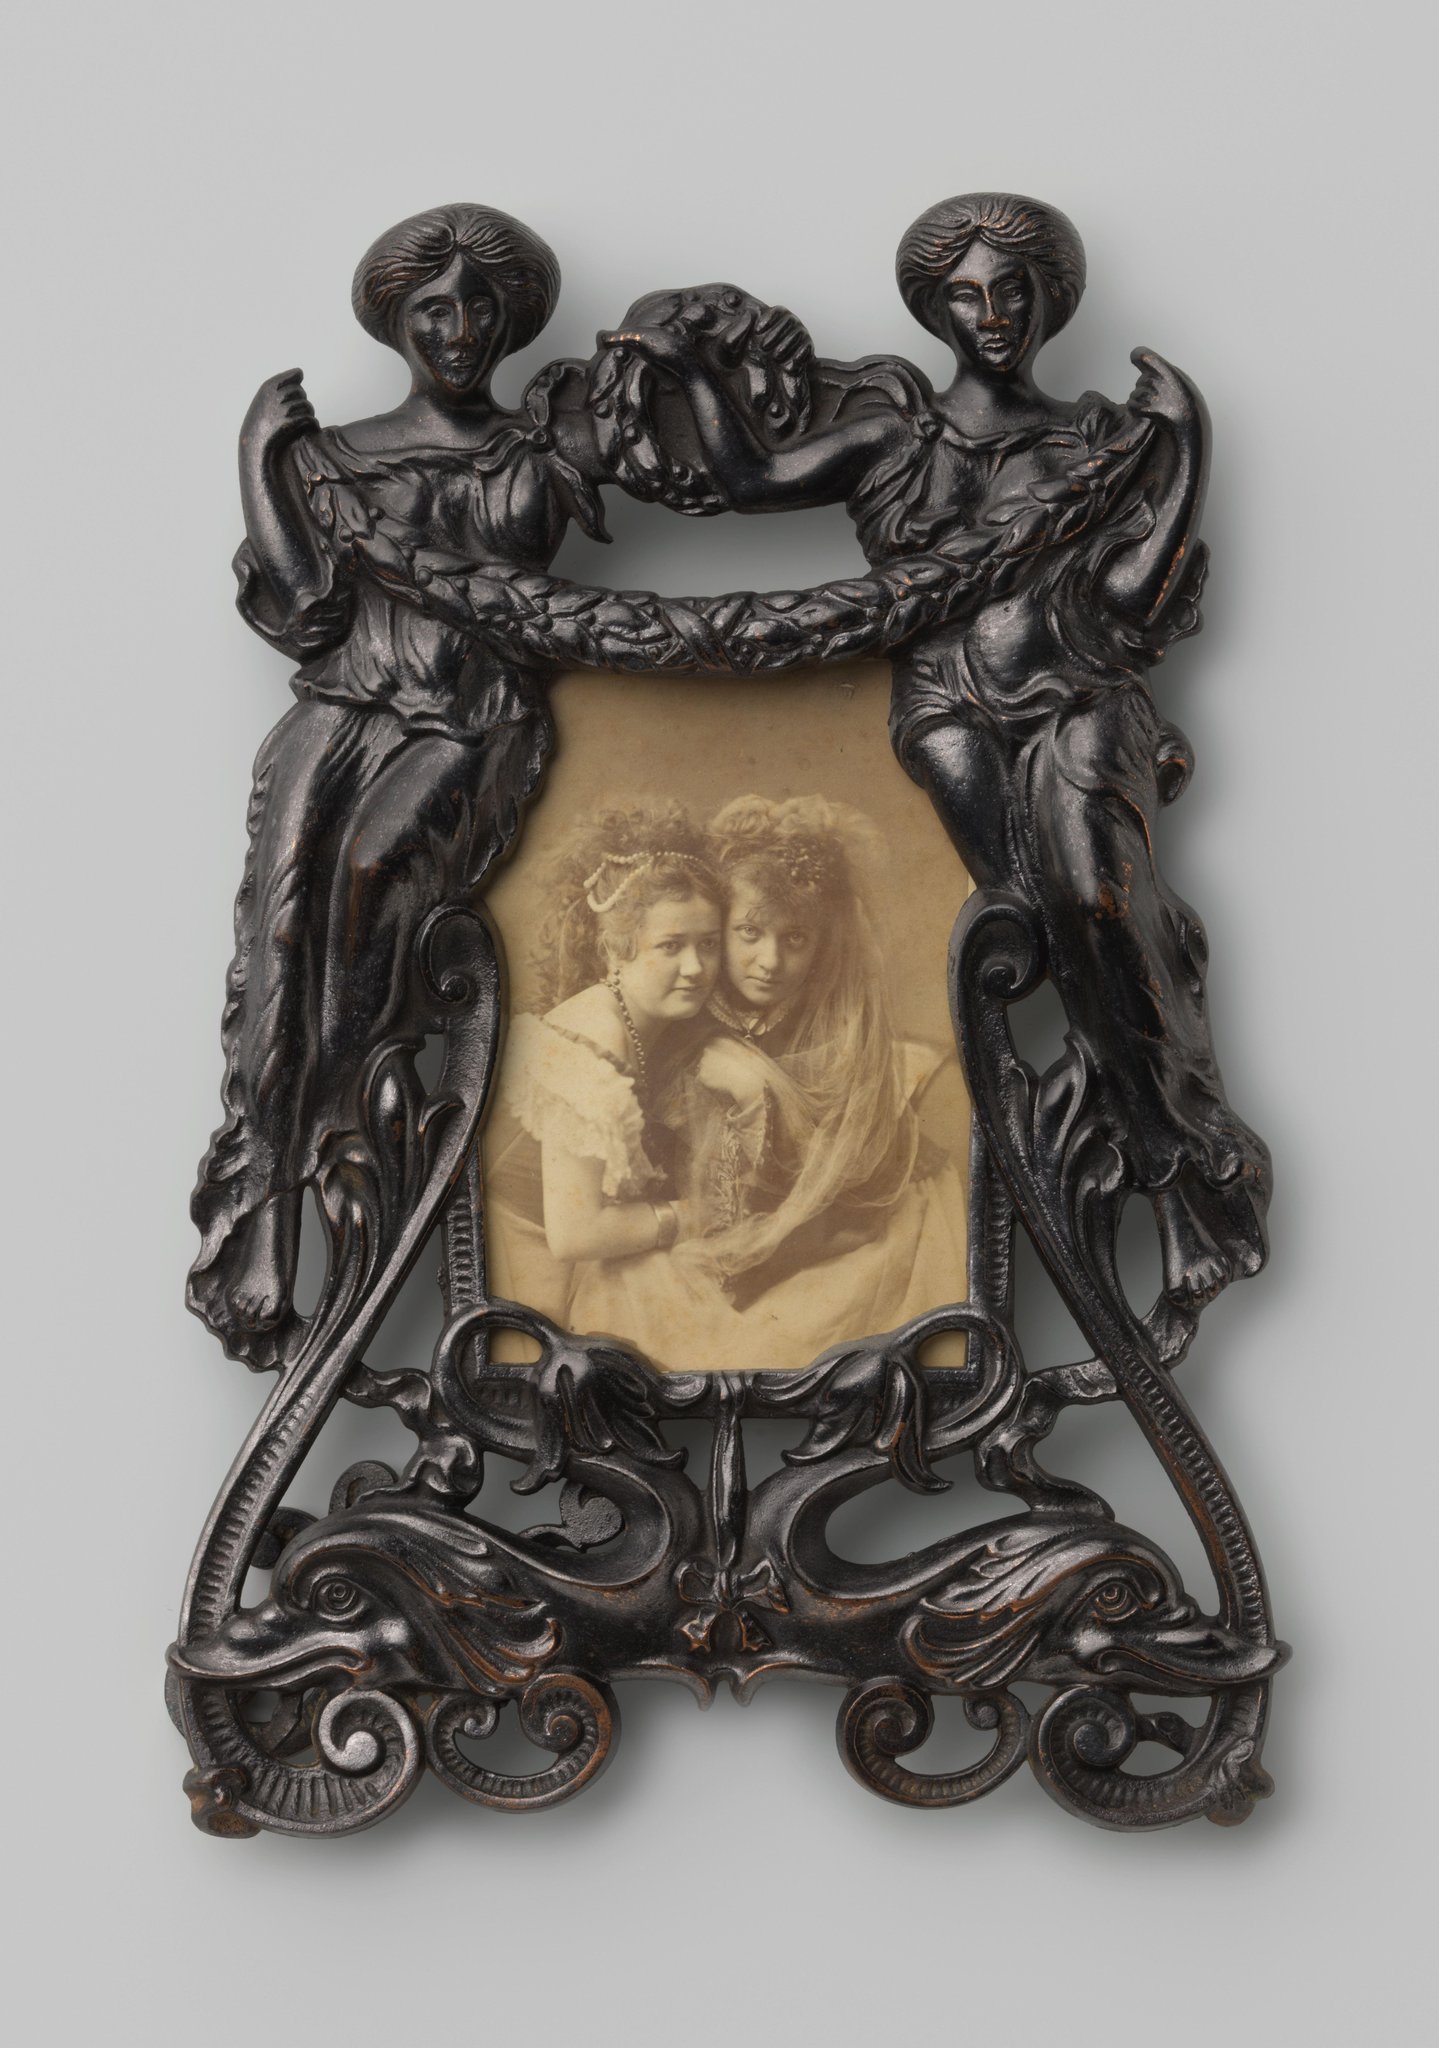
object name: cabinet photograph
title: Portret van twee onbekende vrouwen met kettingen en tule in het haar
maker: Anonymous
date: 1880-1900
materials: cardboard, glass, metal, paper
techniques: albumen print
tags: hairdress, anonymous historical person portrayed - bb - woman